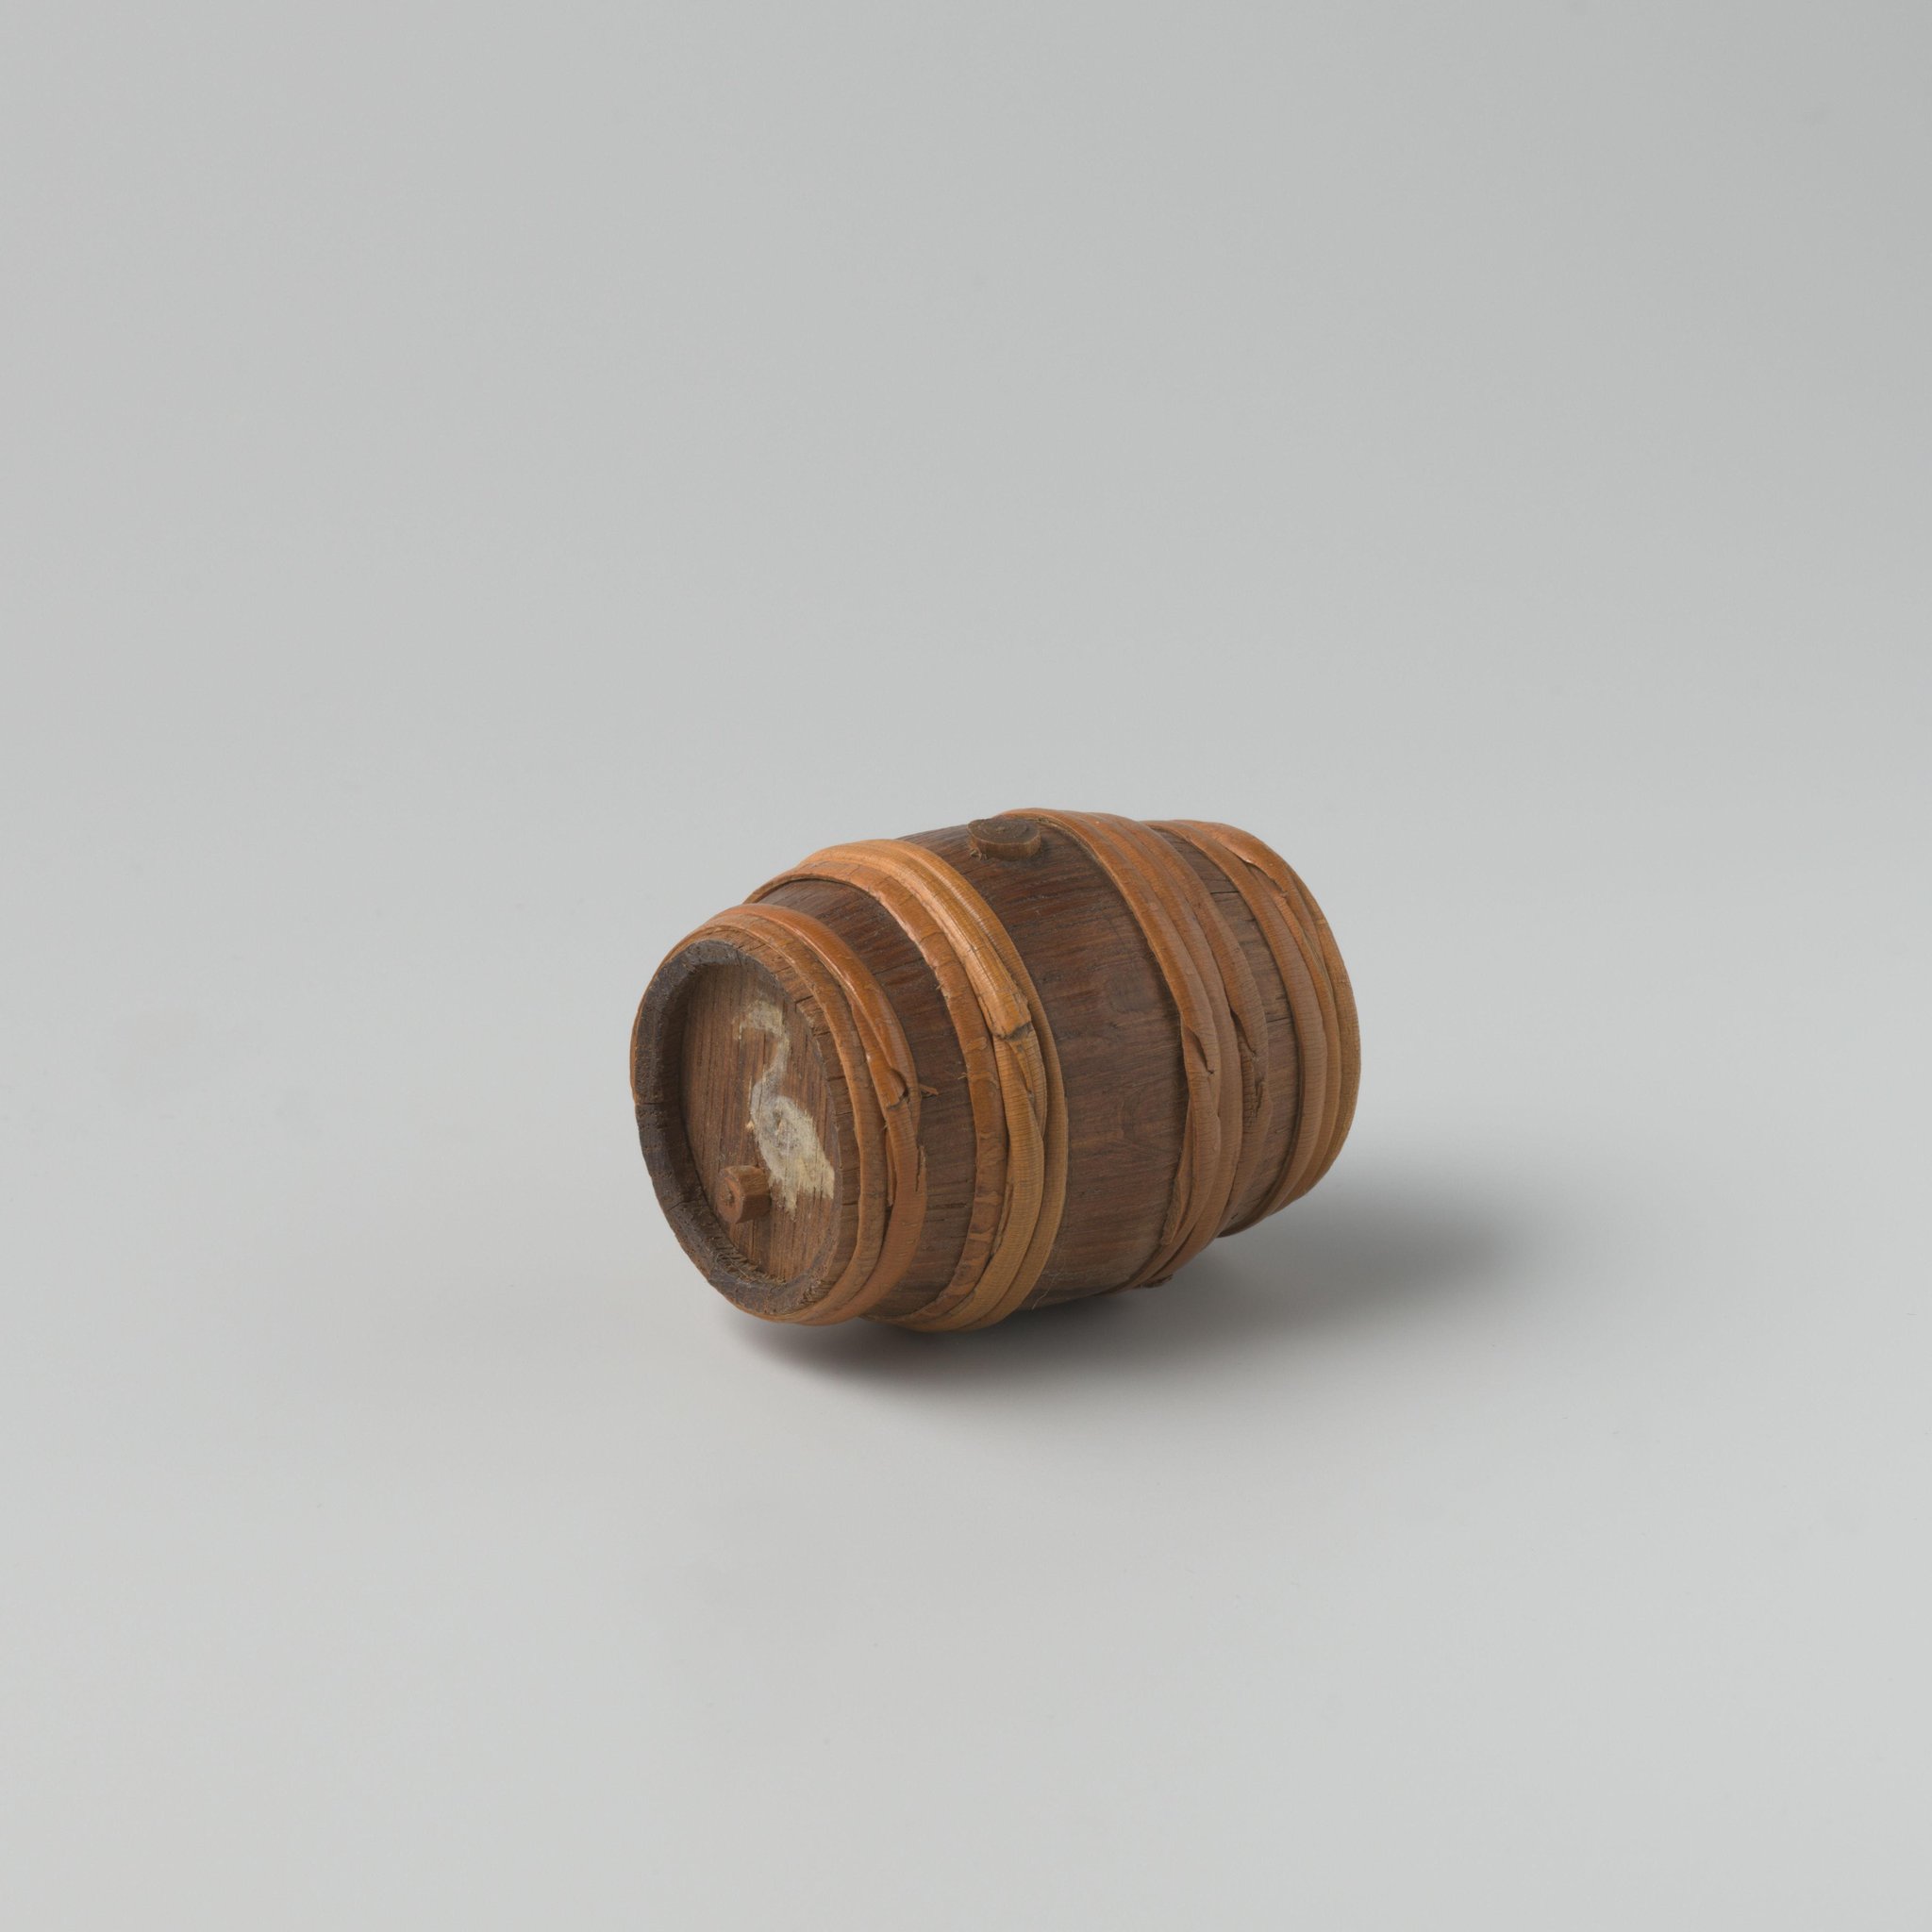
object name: biervat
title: Bier- of wijnvat, van eikenhouten duigen, omwonden door 4 x 3 hoepels van rotan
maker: Anonymous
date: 1690-1710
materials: brass, wood, rattan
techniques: gilding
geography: amsterdam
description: Bier- of wijnvat, van eikenhouten duigen, omwonden door 4 x 3 hoepels van rotan. Op de voorkant is met witte verf een zwaantje geschilderd.